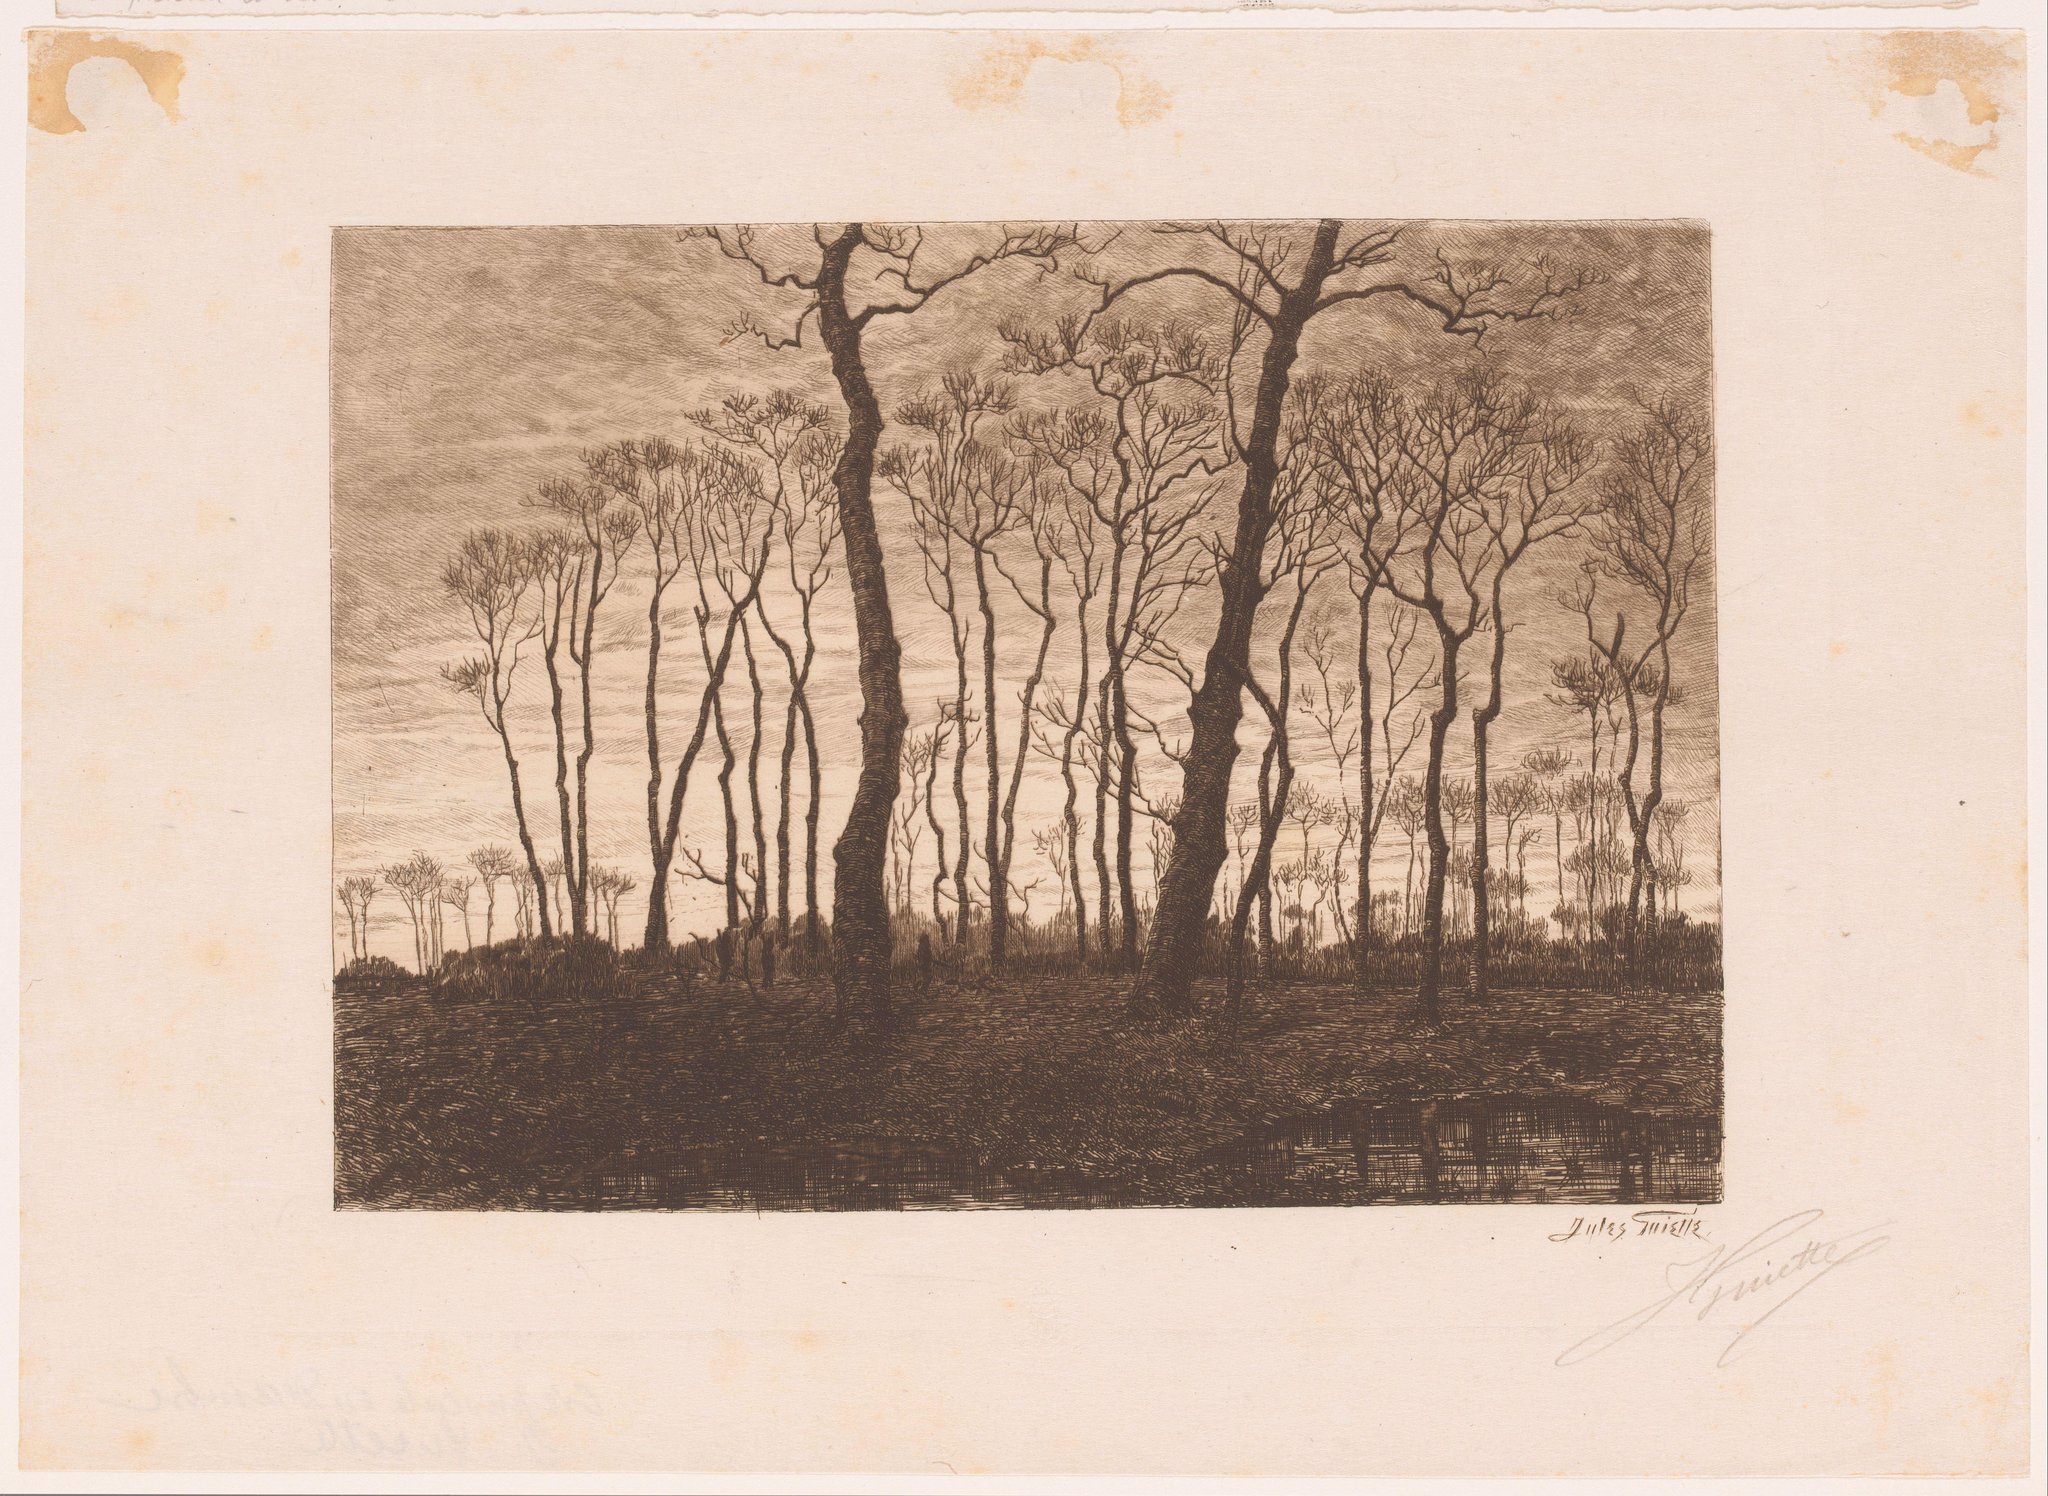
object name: print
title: Schemering in de winter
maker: jules guiette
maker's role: print maker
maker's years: 1852-1901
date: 1862-1901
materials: paper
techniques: drypoint, etching, intaglio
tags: dusk, evening twilight, deciduous forest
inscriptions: collector's mark: Lugt 2228, workshop stamp: ‘Antwerpsche Etsers 1880’